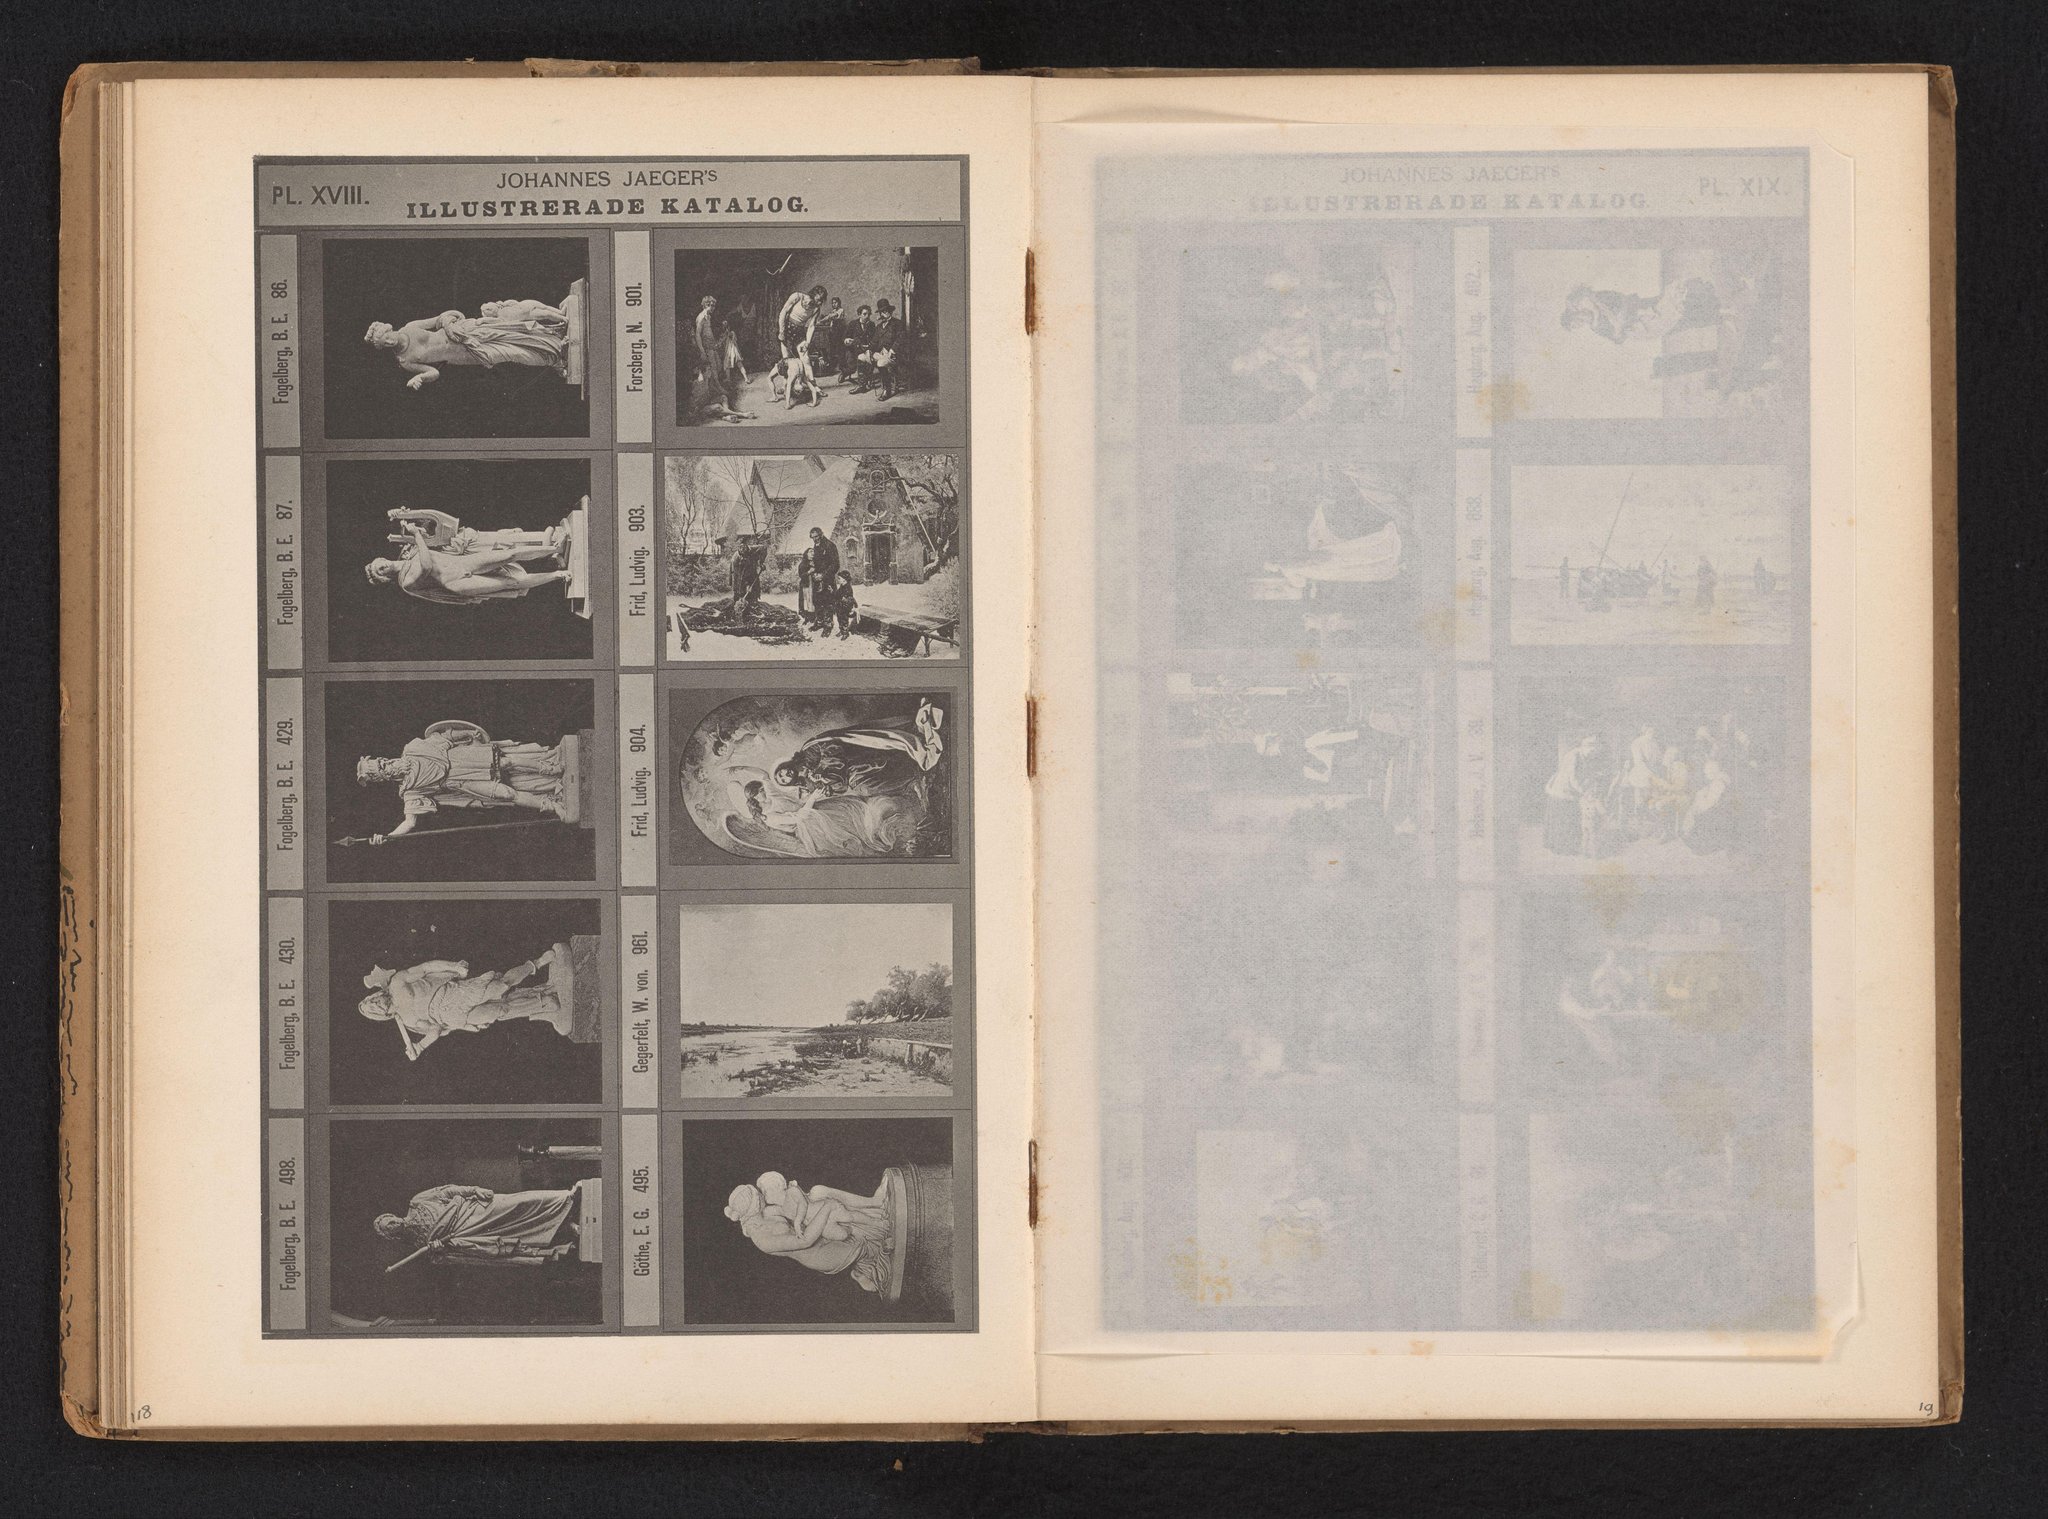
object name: page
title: Johannes Jaeger's Illustrerade Katalog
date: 1872-1882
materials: paper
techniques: photograph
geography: stockholm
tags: sculpture, picture, painting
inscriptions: number: ‘PL. XVIII.’